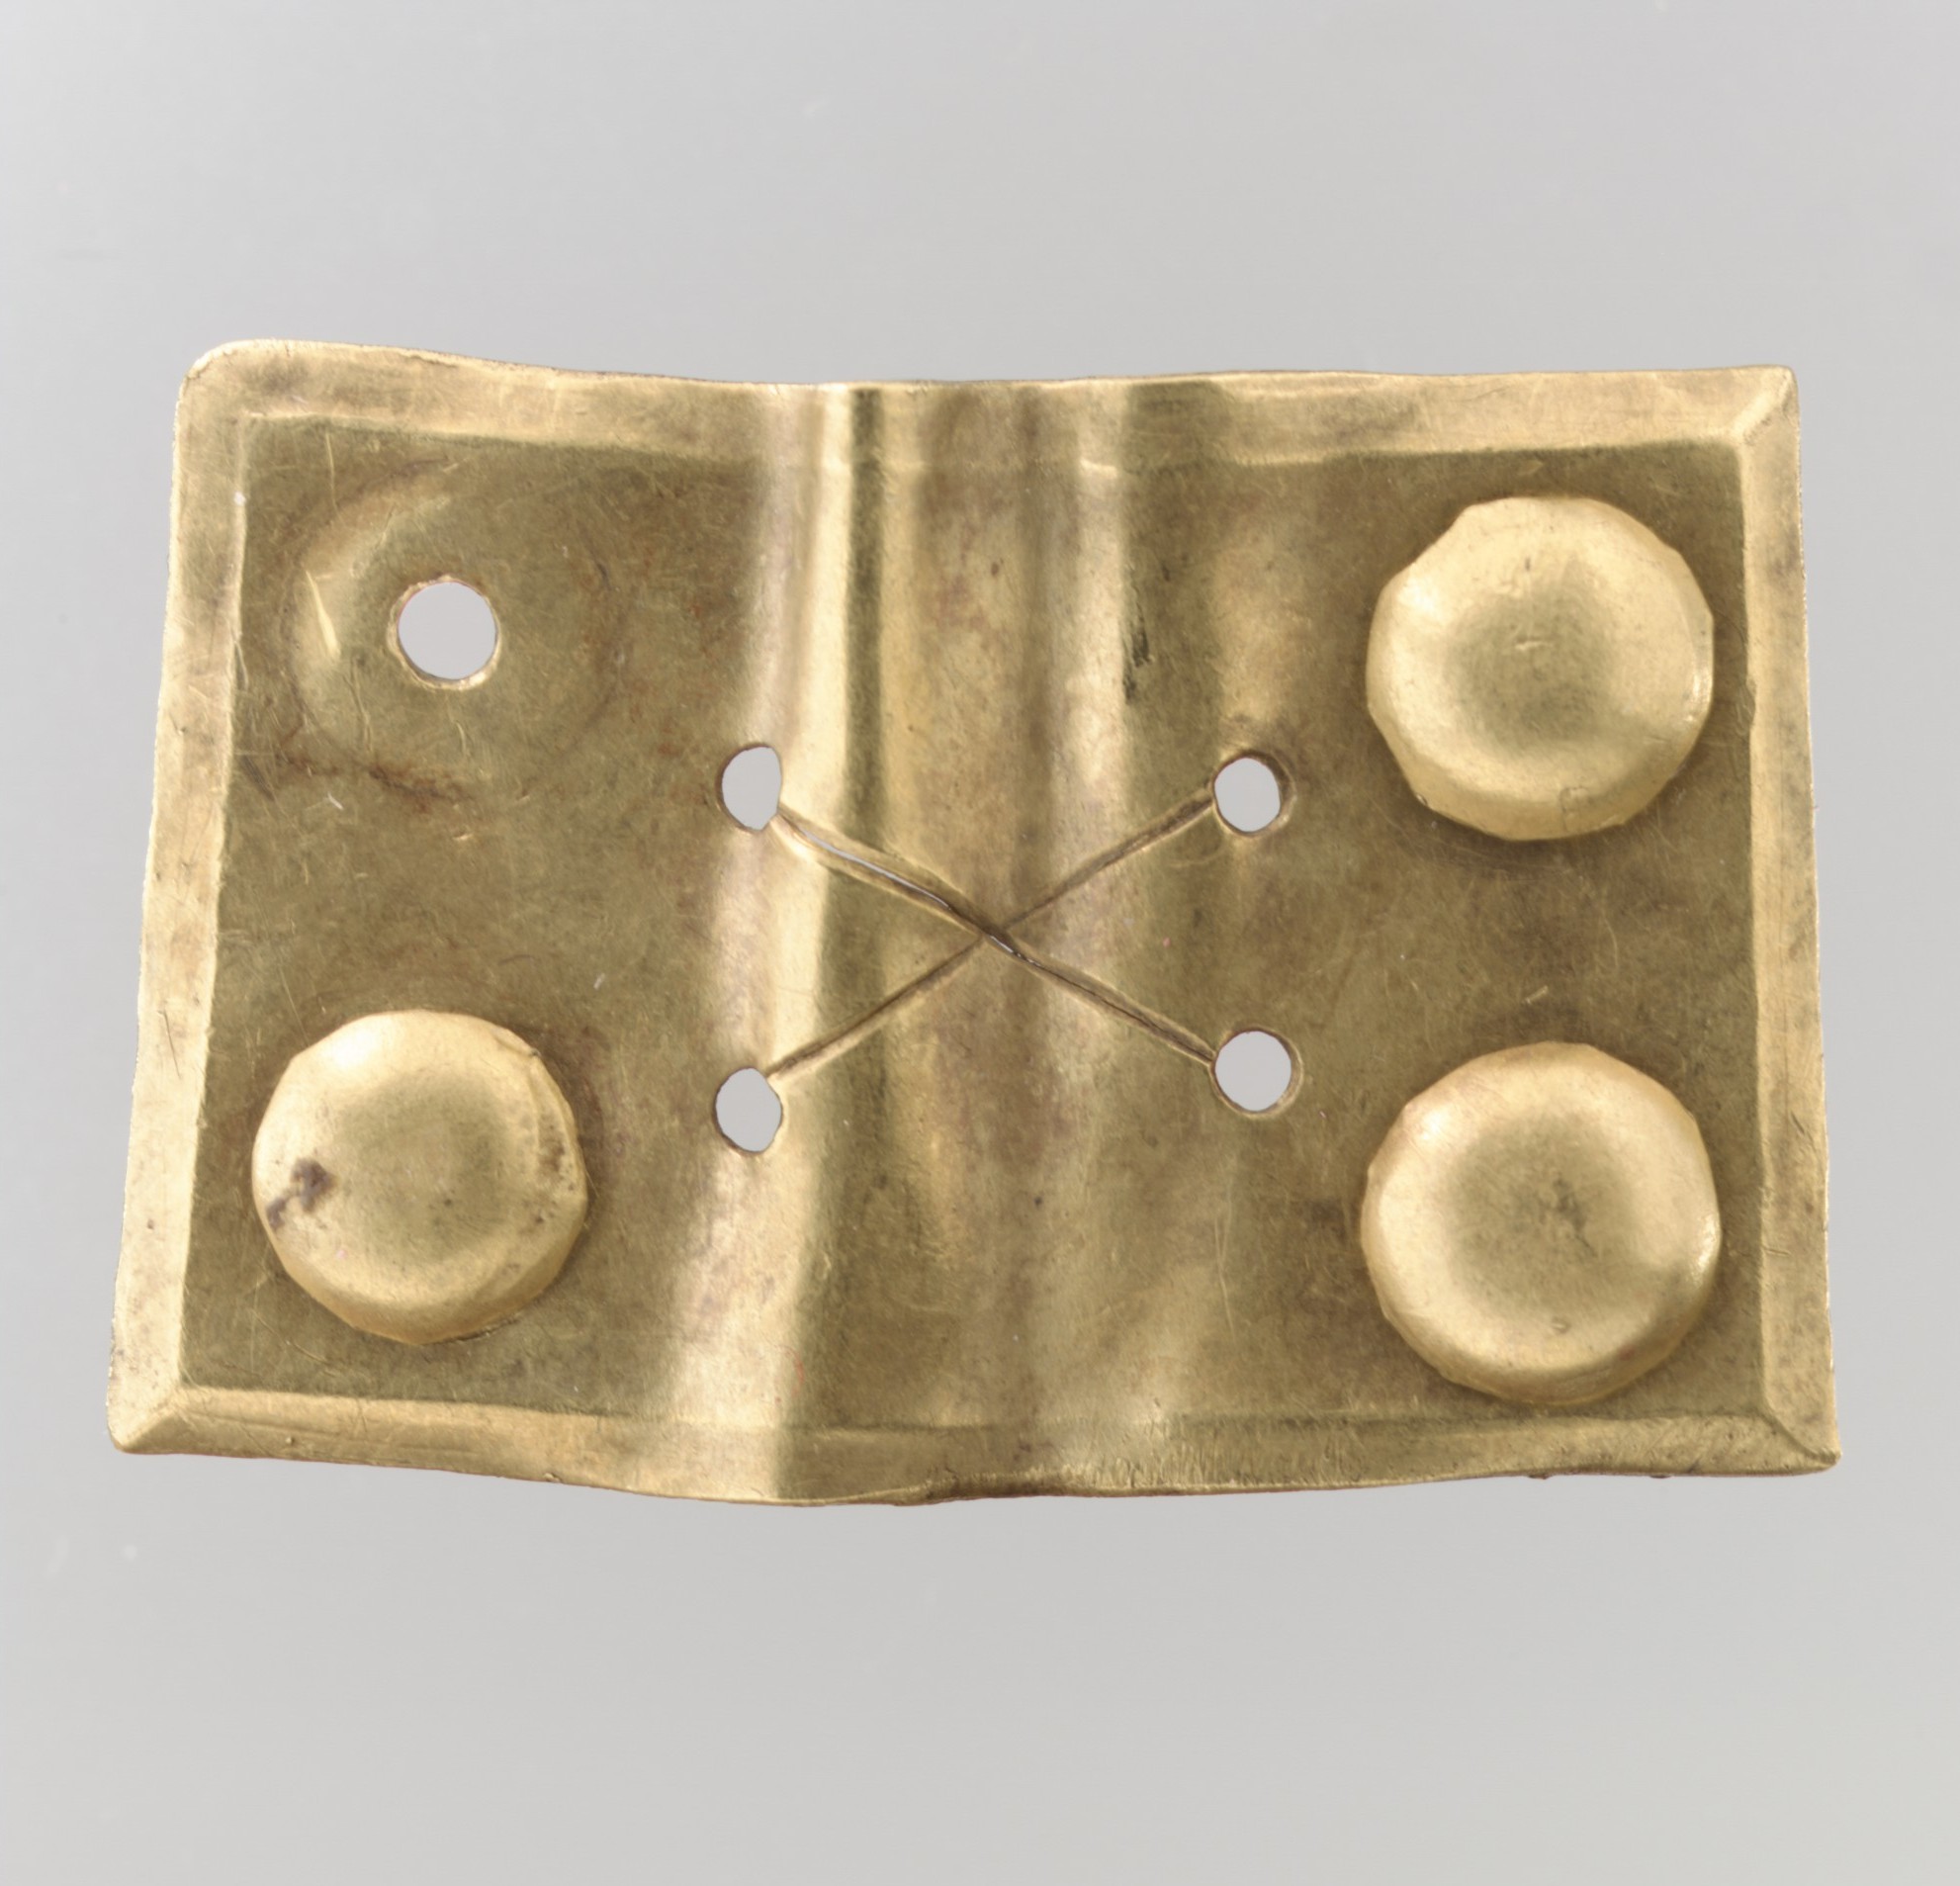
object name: belt mount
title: Gold Belt Mount (Unfinished)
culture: avar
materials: gold